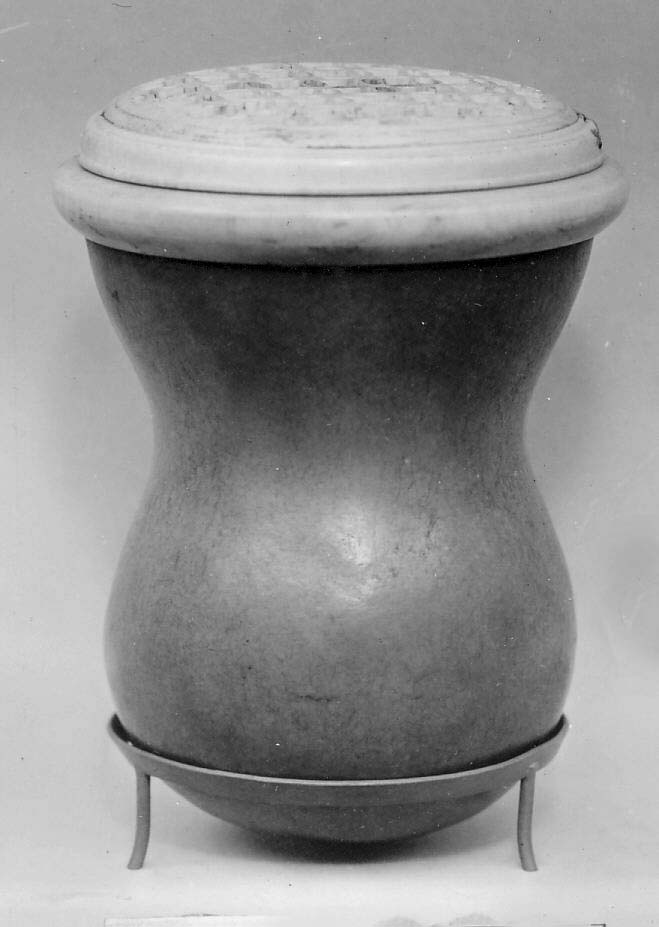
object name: cricket cage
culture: chinese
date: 1701-1900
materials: ivory